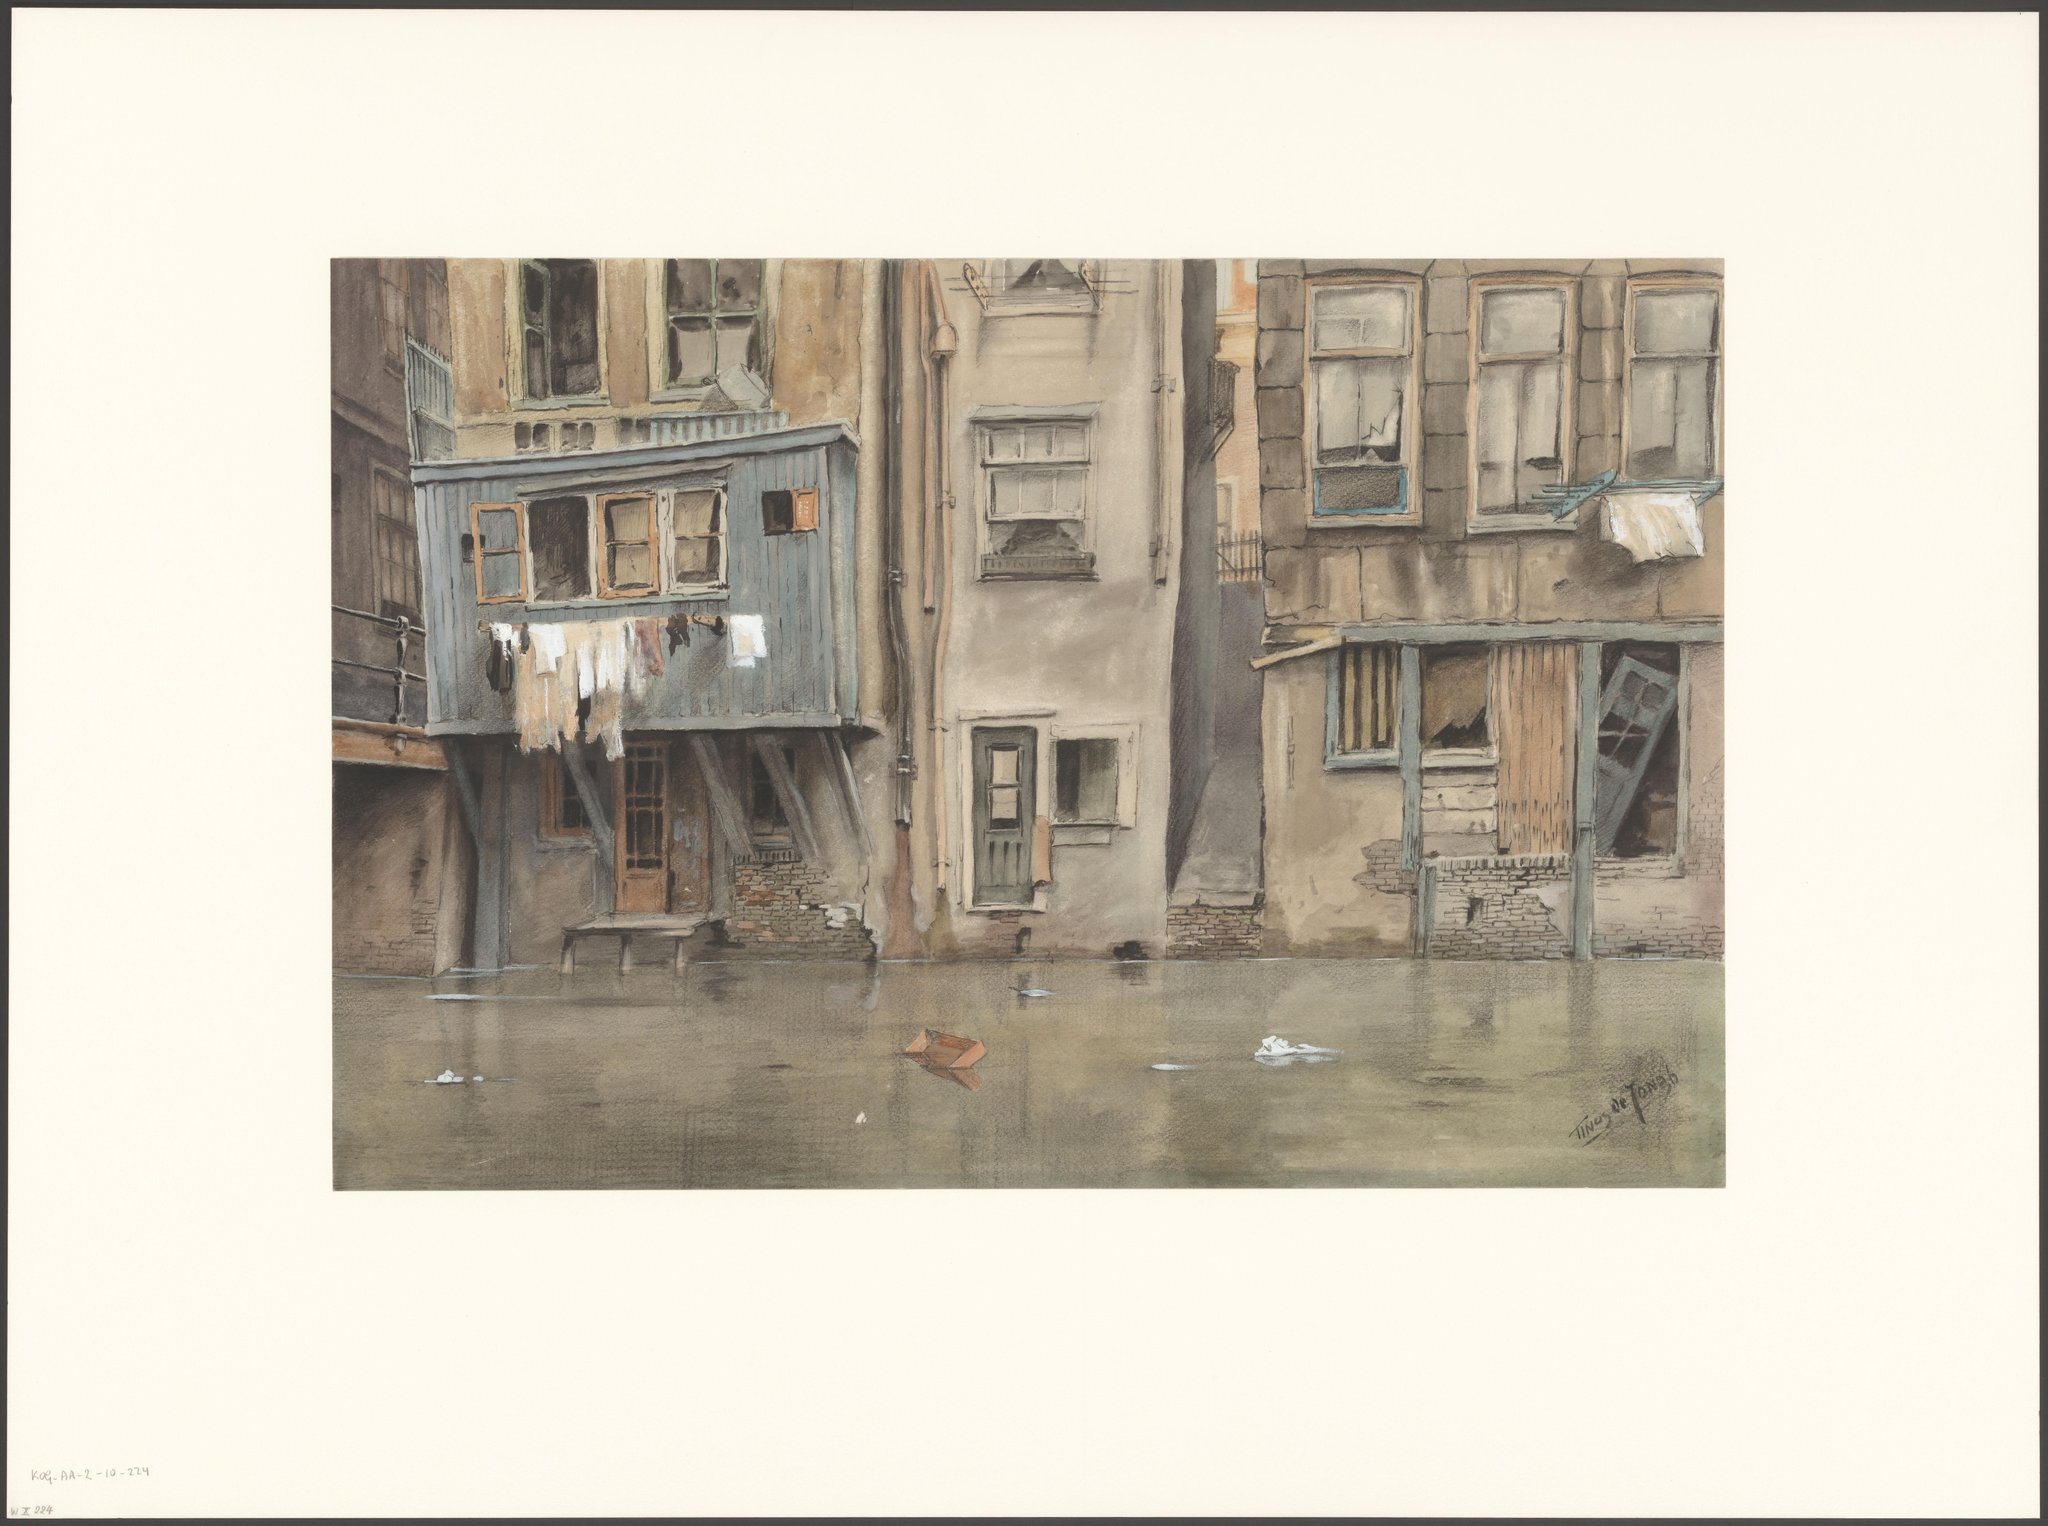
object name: drawing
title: Gezicht op de onderkant van huizen aan het water van de Oudezijds Achterburgwal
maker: tinus de jongh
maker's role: print maker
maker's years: 1885-1942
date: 1895-1942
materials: chalk, paint, gouache, paper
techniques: brush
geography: amsterdam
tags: city-view in general; 'veduta', canal, façade (of house or building)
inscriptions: signature: ‘TinusdeJongh’, collector's mark: Lugt 800a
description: Tekening binnen de Atlas Van Eck ingedeeld op wijknummer 10.